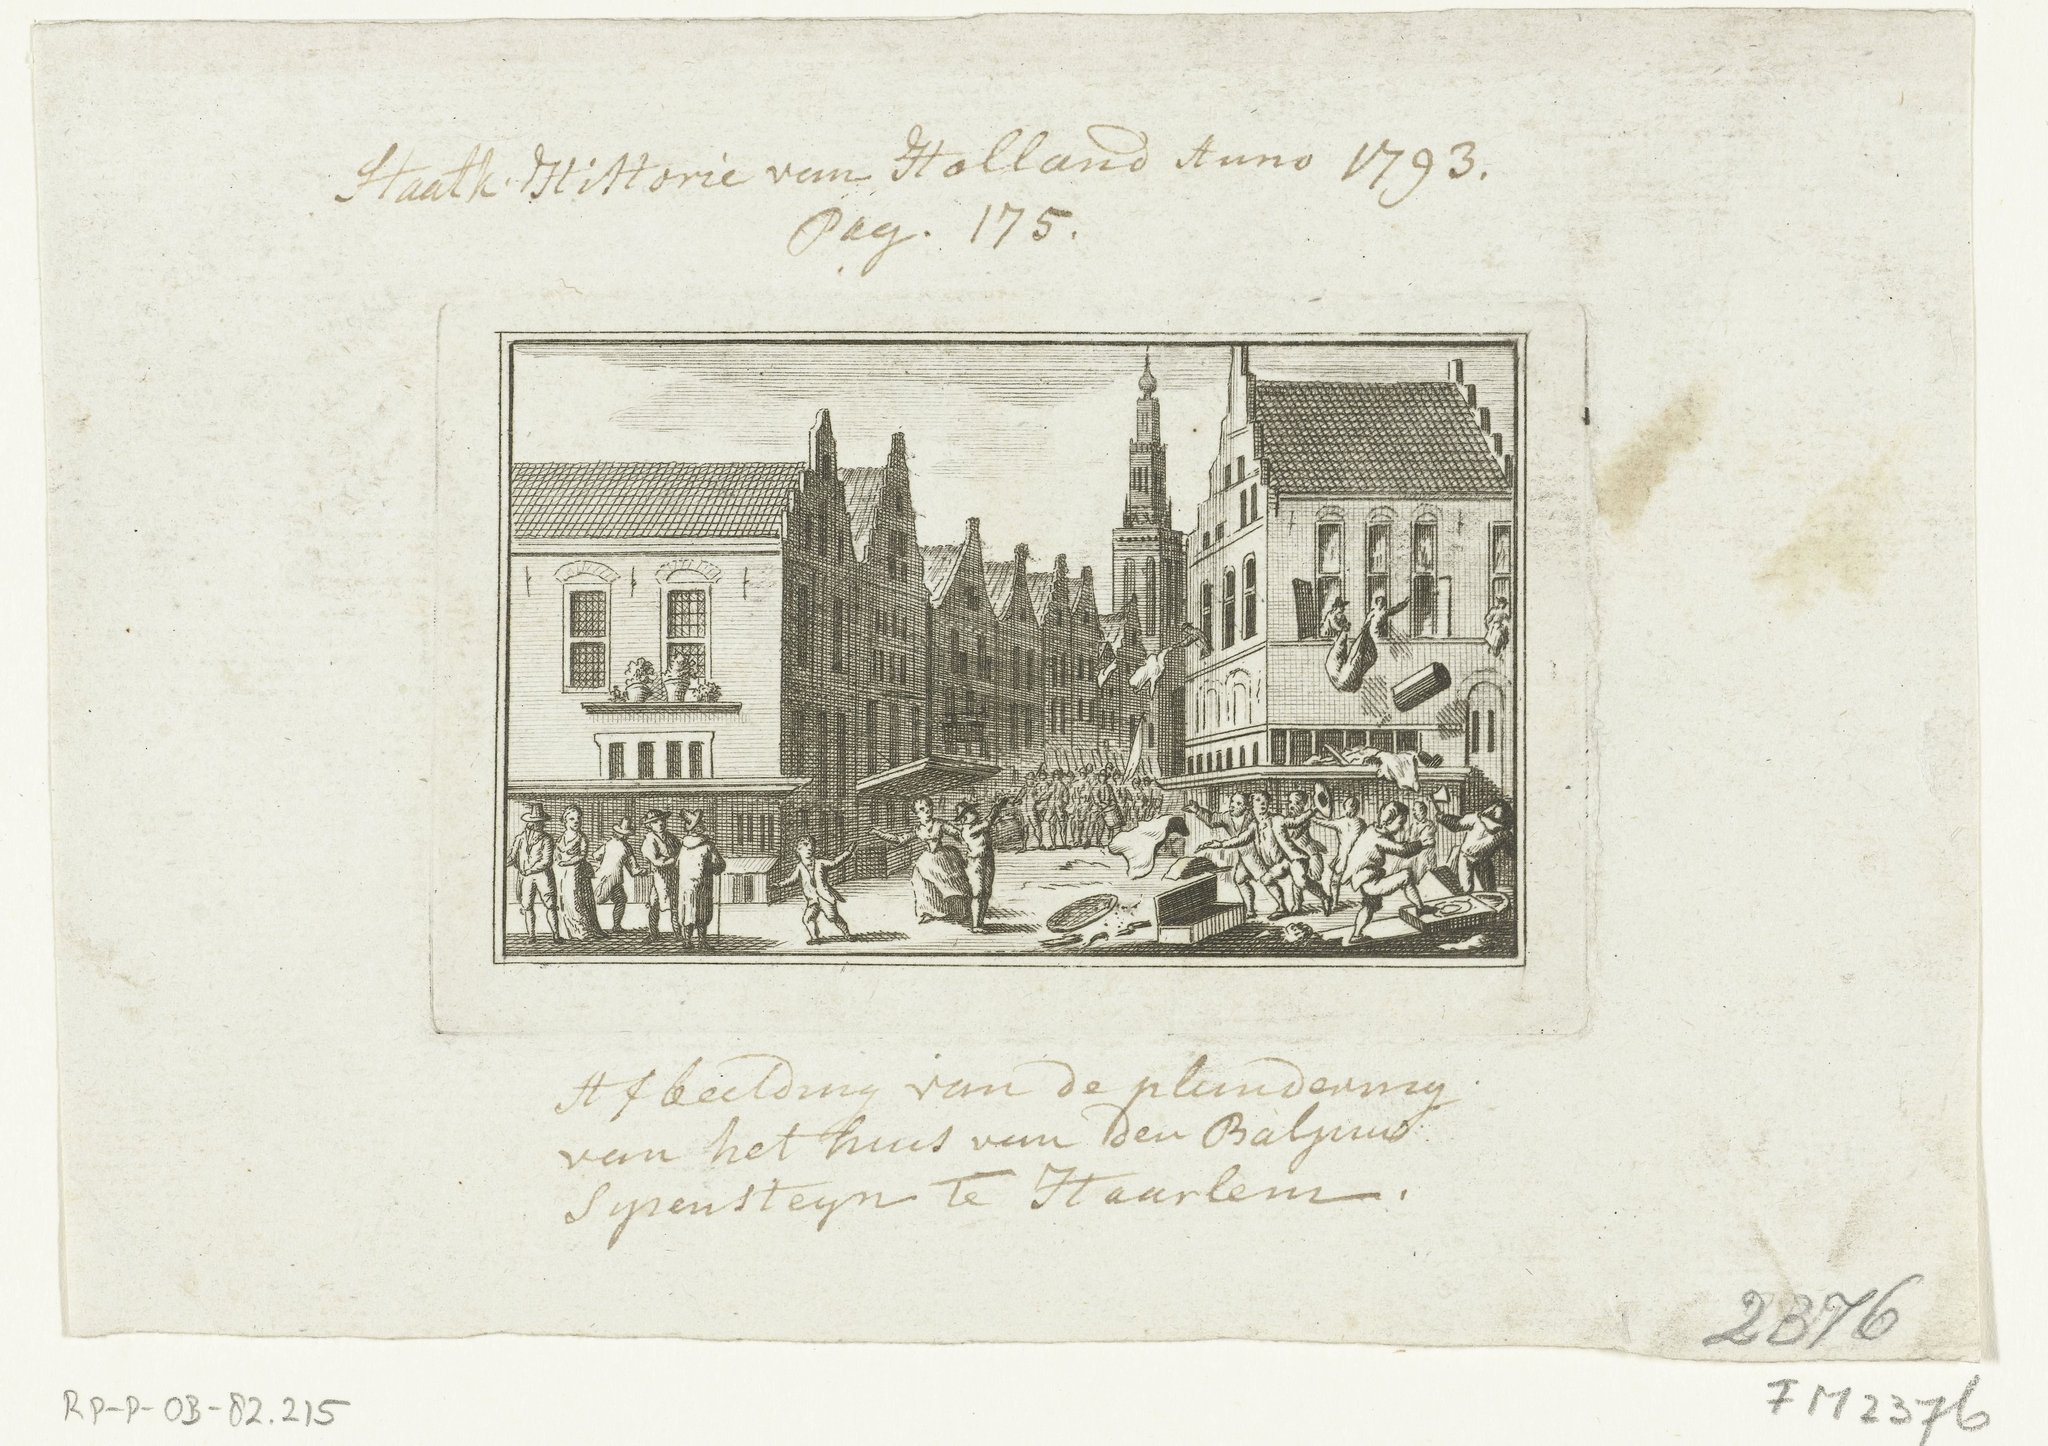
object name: history print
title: Plundering van het huis van de baljuw te Haarlem, 1672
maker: Anonymous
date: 1791-1793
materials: paper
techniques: etching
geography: northern netherlands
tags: street-fights, riots, haarlem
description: Plundering van het huis van de baljuw van Brederode, Asc. van Sypesteyn, te Haarlem, 4 juli 1672.